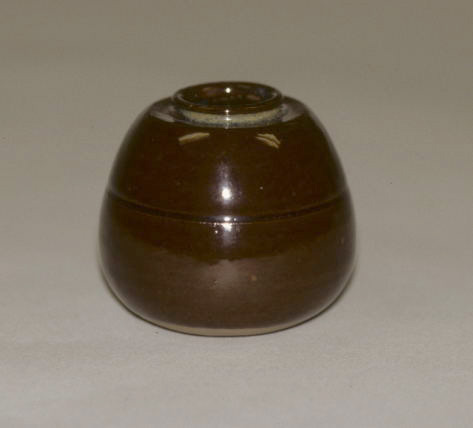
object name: tea jar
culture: japanese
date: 1680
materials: clay, glaze